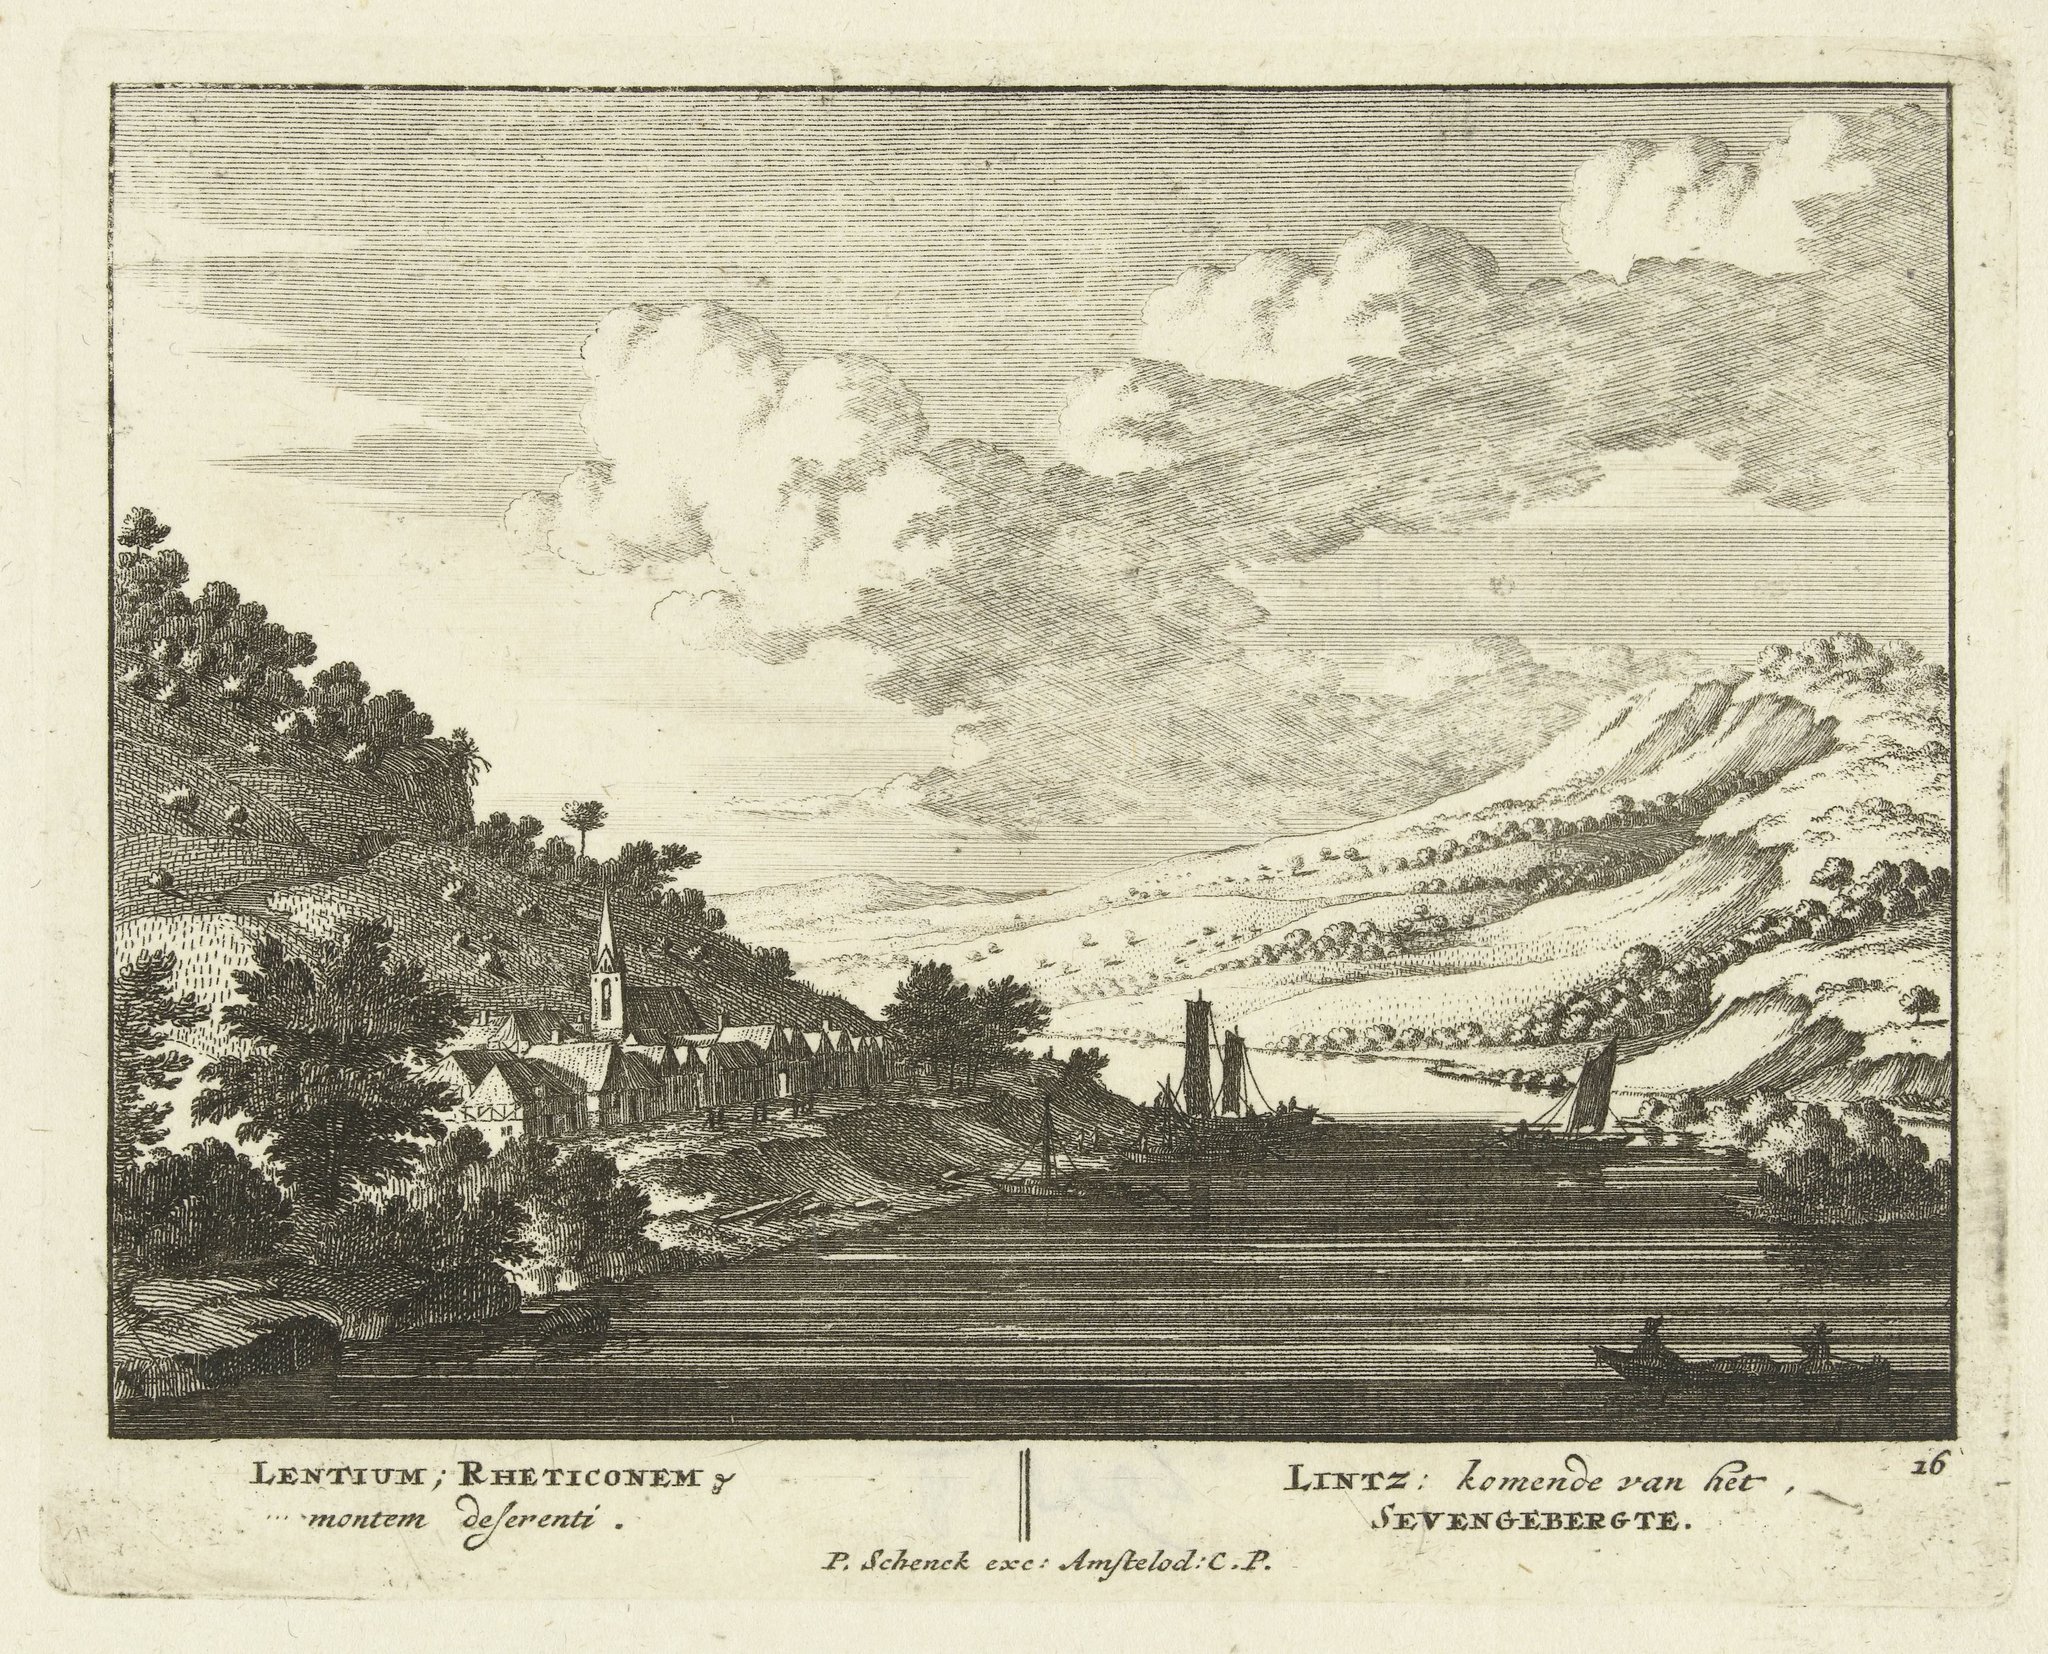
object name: print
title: Linz aan de Rijn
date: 1694-1697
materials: paper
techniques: etching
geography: amsterdam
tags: river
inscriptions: collector's mark: Lugt 2228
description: Prent uit een serie van 71 prenten met Rijnlandschappen, gezichten op vorstelijke paleizen en stadsgezichten uit Den Haag en Amsterdam.